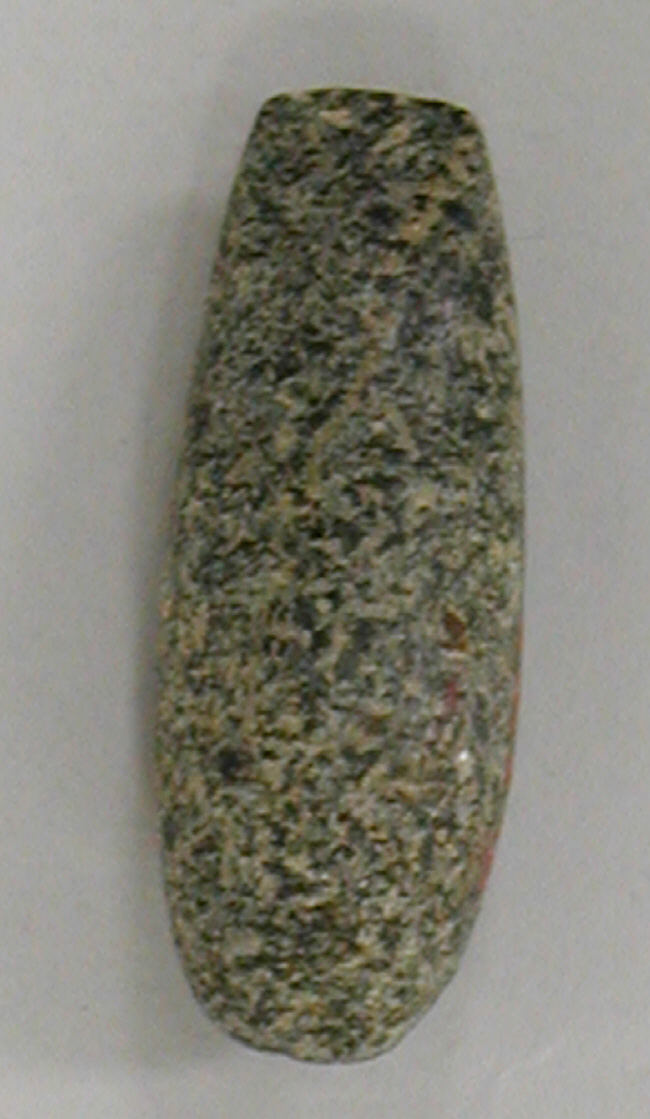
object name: celt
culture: costa rican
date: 1501-1600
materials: stone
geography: costa rica